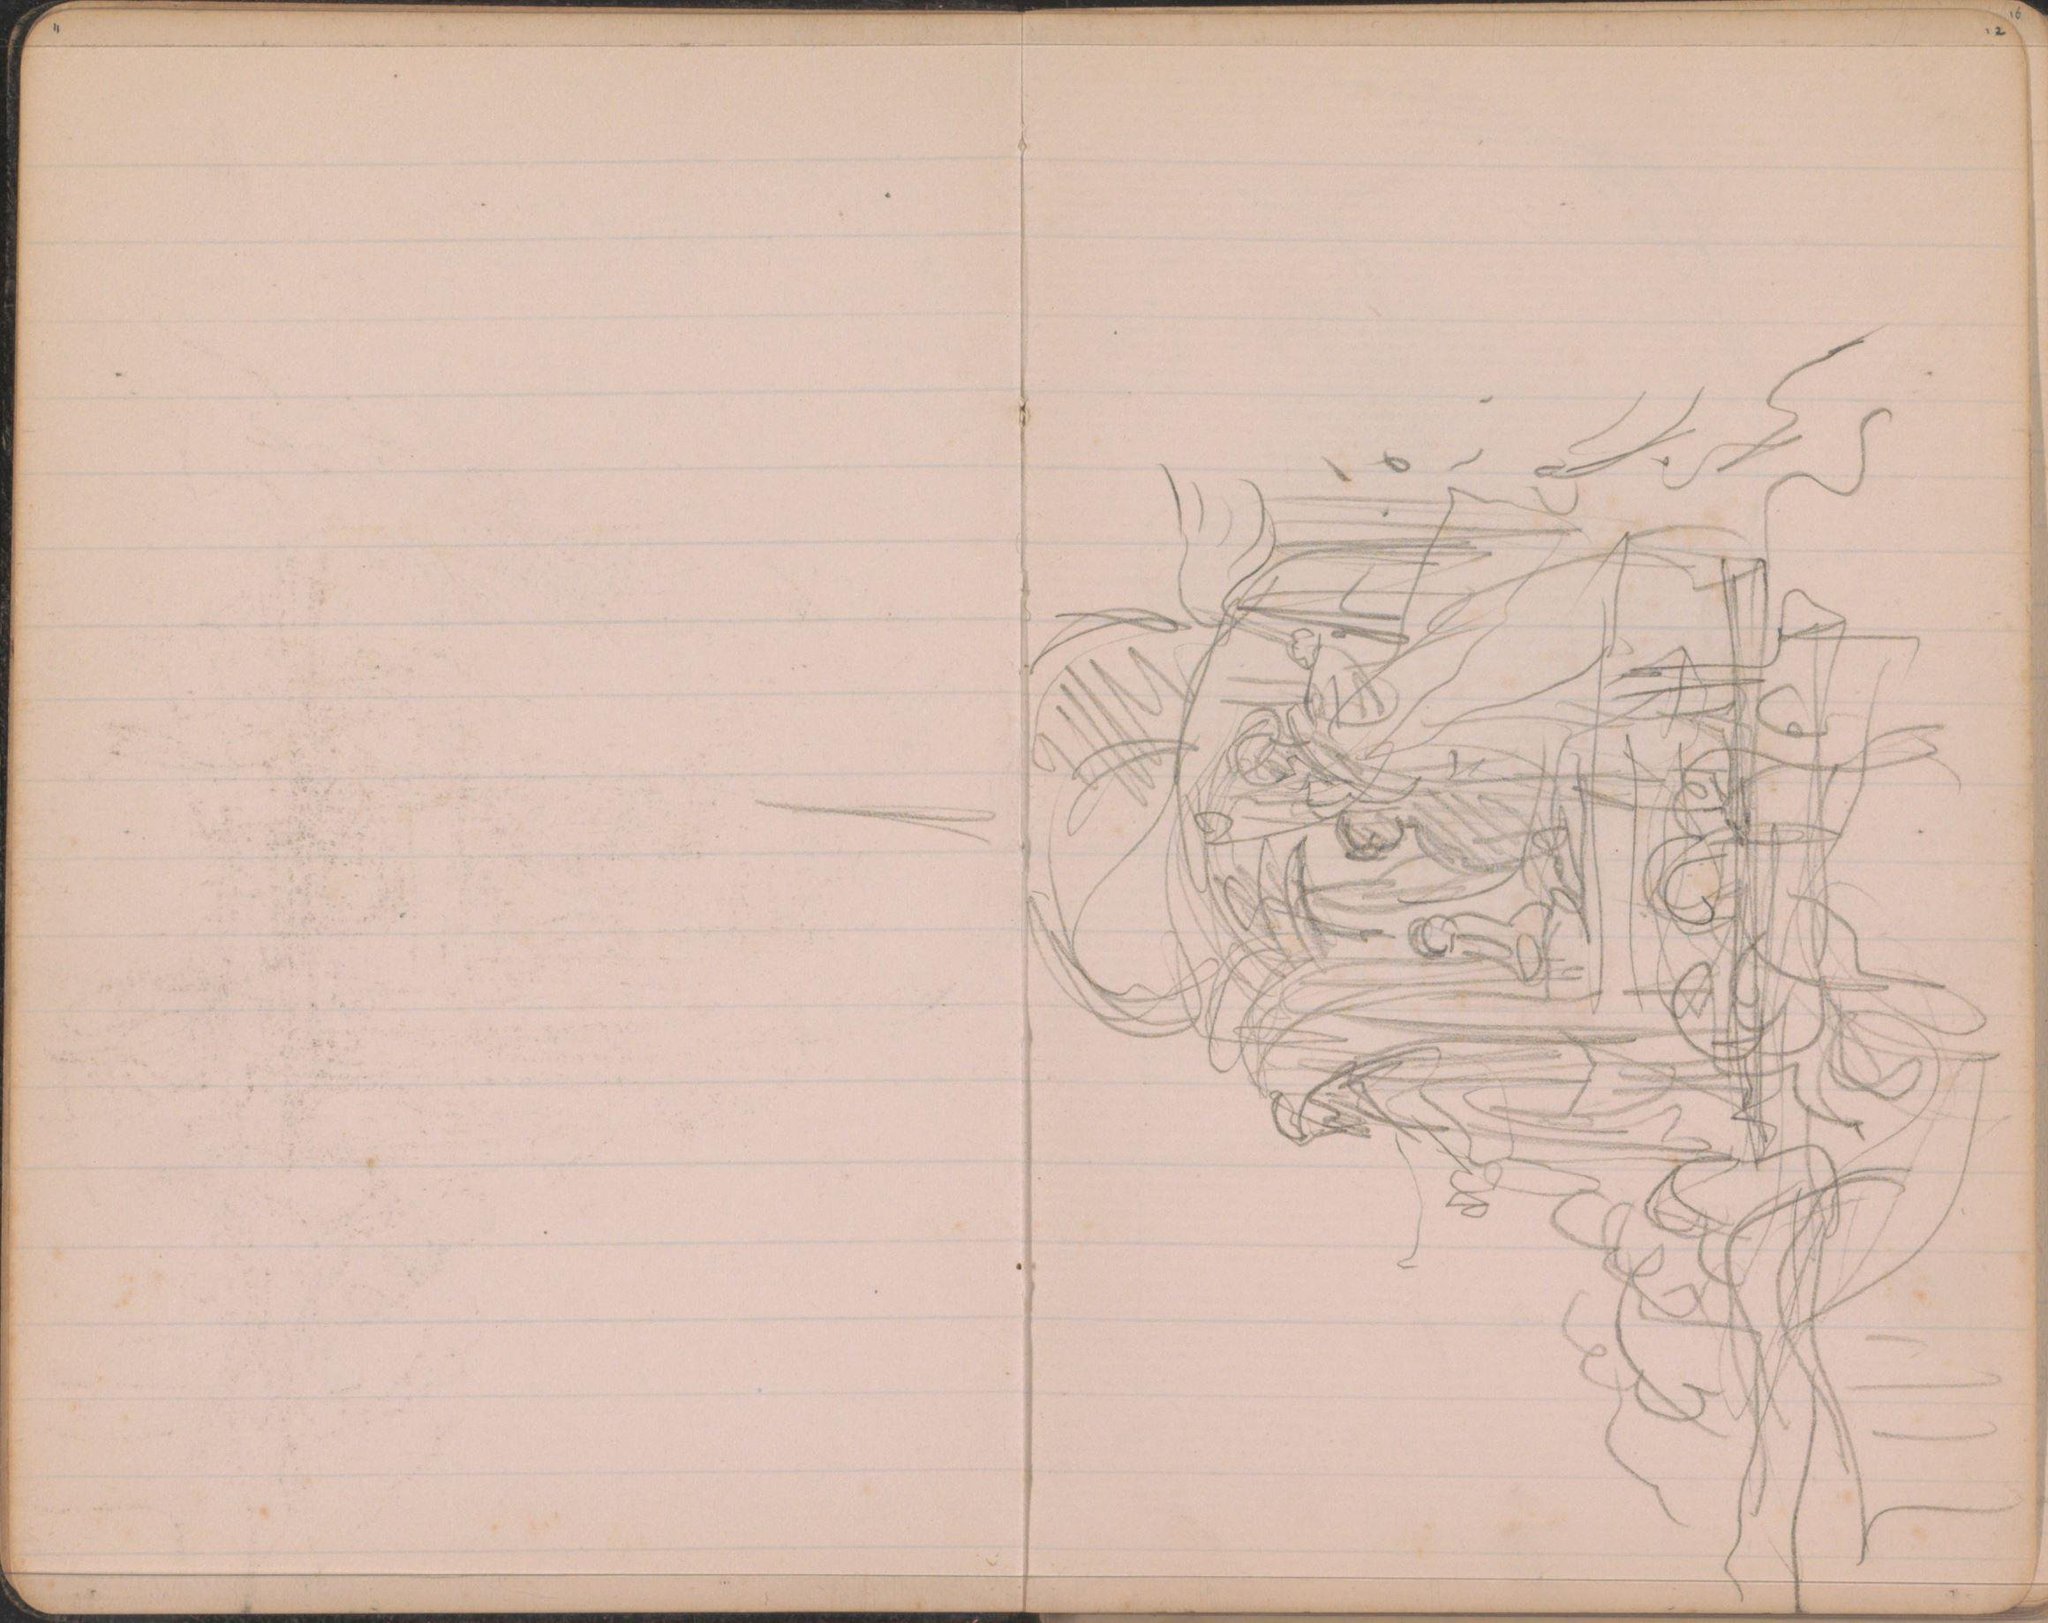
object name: sketchbook leaf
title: Architectuurstudie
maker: marius bauer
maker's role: draughtsman, print maker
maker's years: 1867-1932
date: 1897-1898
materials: pencil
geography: india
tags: temple, shrine ~ hinduism, buddhism, jainism, sculpture, dome ~ architecture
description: Koepeldak met een spits en beeldhouwwerken. Mogelijk een detail van een Hindoeïstische plaats van aanbidding. Pagina 11 en 12 uit een schetsboek met 84 bladen.